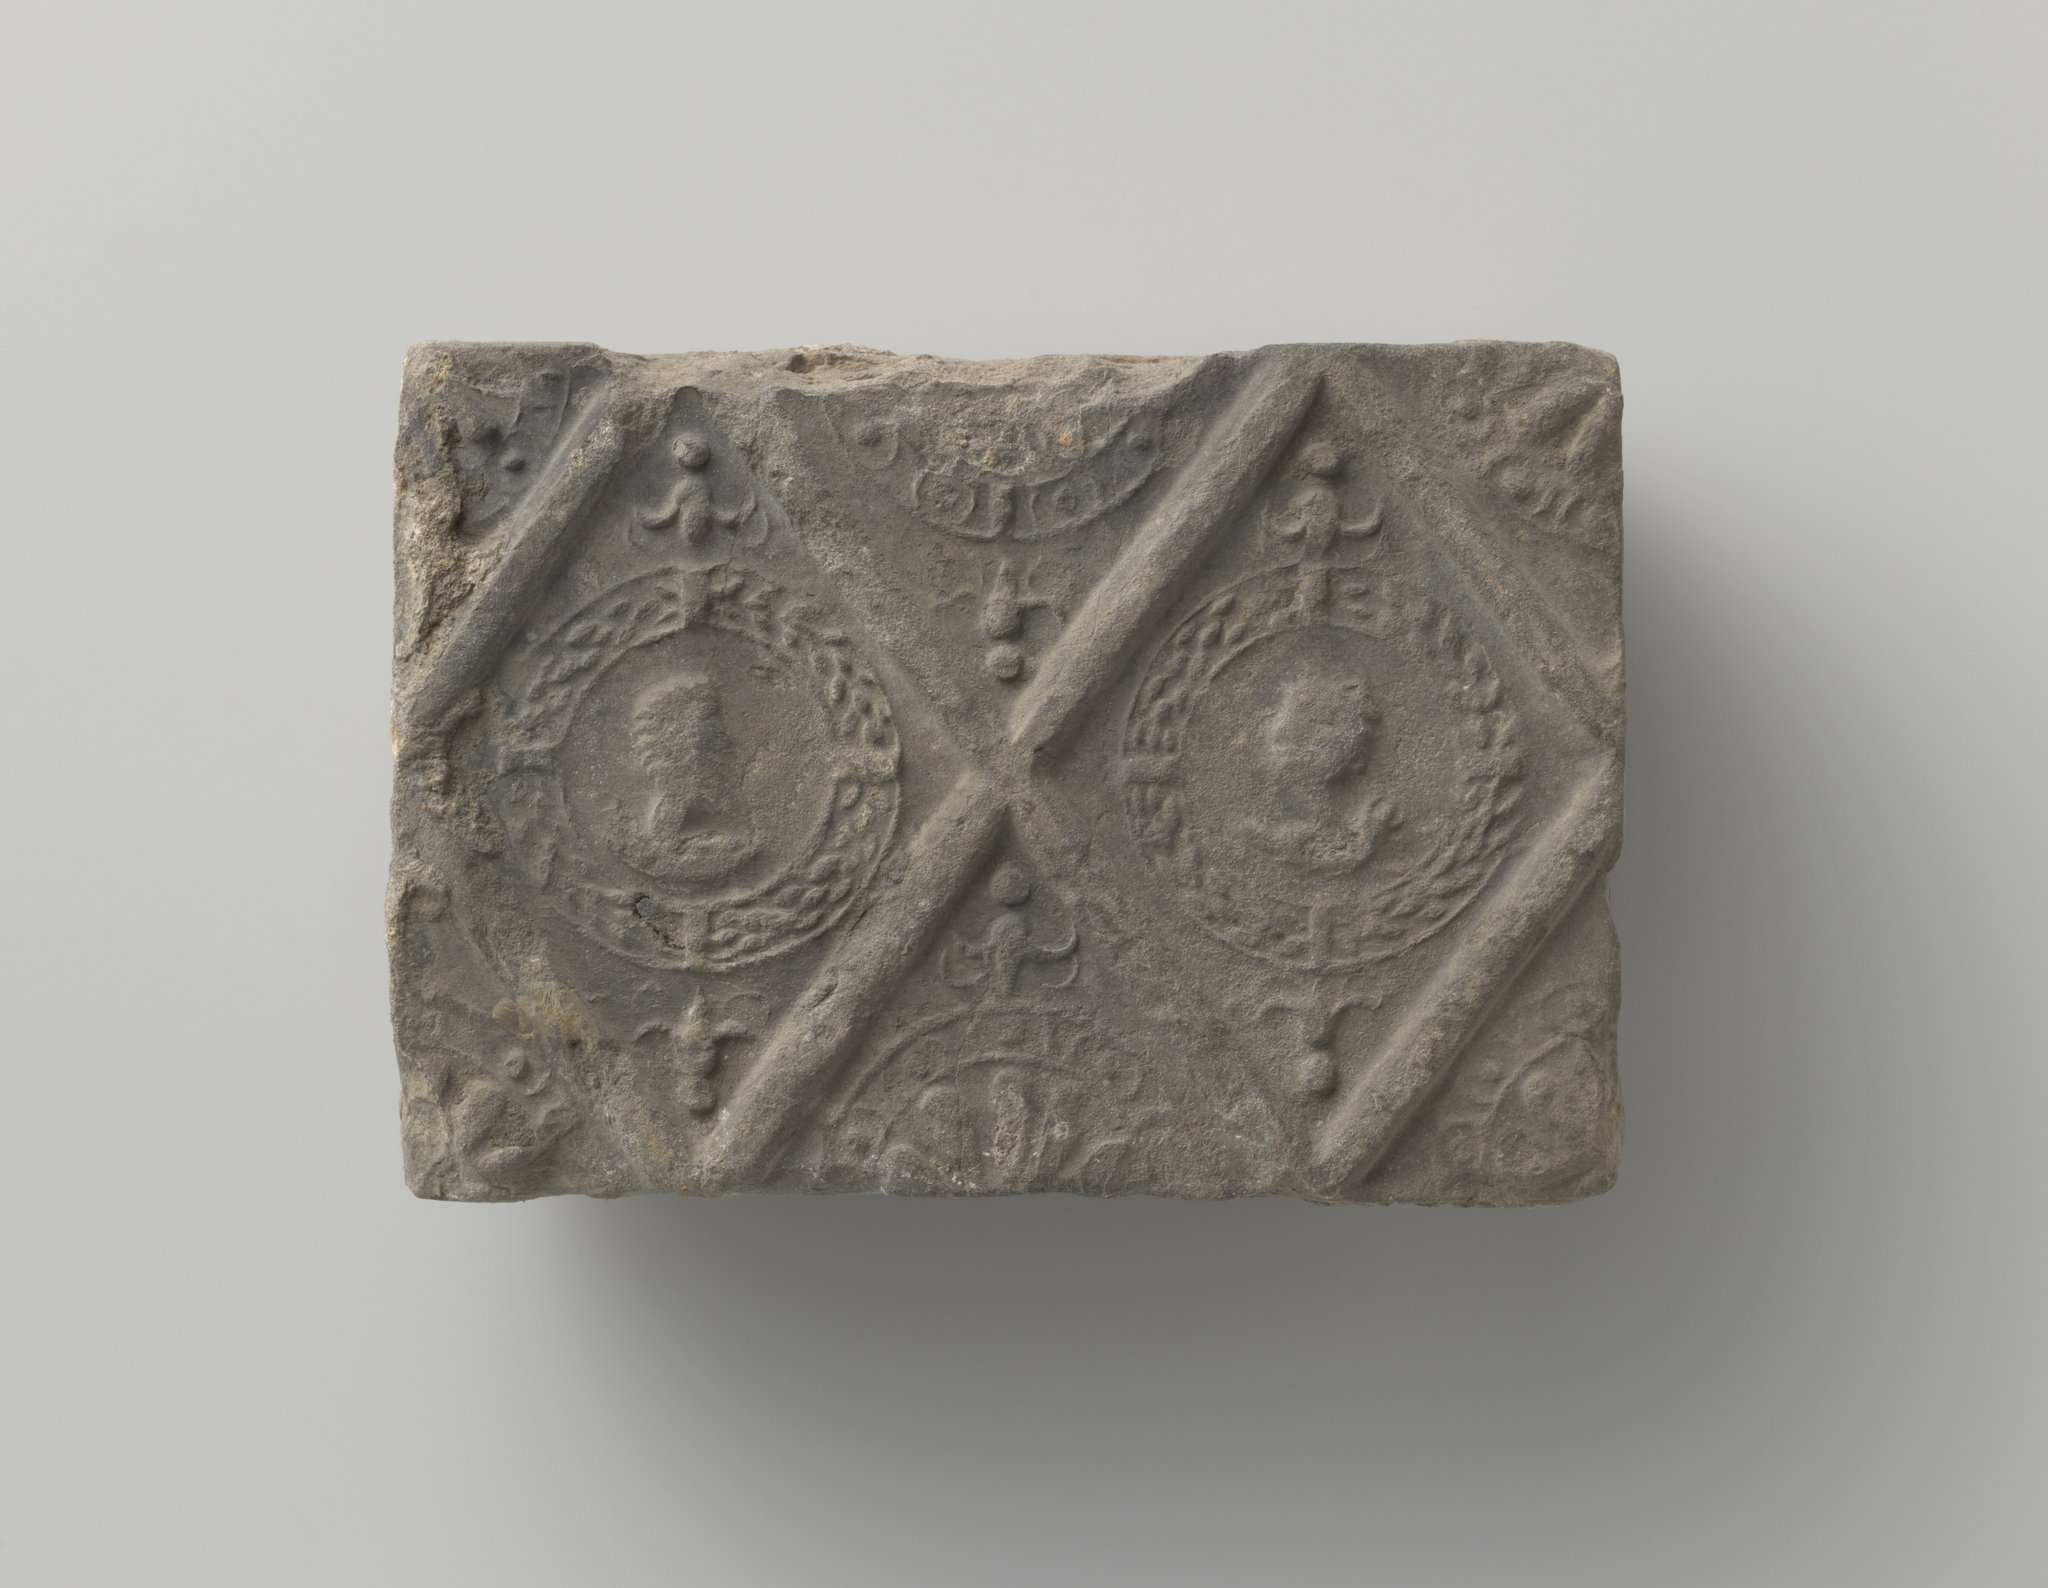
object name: hearthstone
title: Haardsteen van gebakken aarde met ruitvormige verdeling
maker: Anonymous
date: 1550-1599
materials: earthenware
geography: northern netherlands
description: haardsteen met een voorstelling van een mannen- en vrouwenkop en profil, geplaatst in twee geprofileerde ruiten. De halve en kwart ruiten aan de boven- en onderkant zijn opgevuld met bloemversieringen in lauwerkansen.